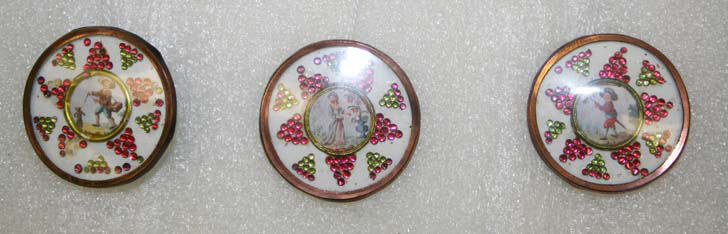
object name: button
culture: french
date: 1770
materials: glass, ivory, mica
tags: children